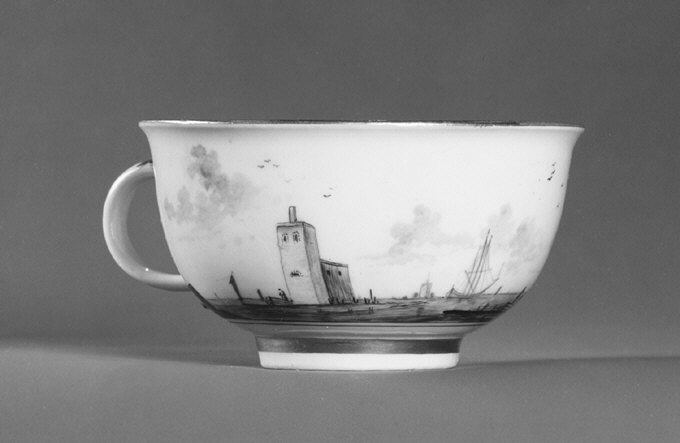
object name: cup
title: Cup (part of a service)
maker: meissen manufactory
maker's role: manufactory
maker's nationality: german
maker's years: 1710-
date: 1701-1800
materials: hard paste porcelain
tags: birds,buildings,ships